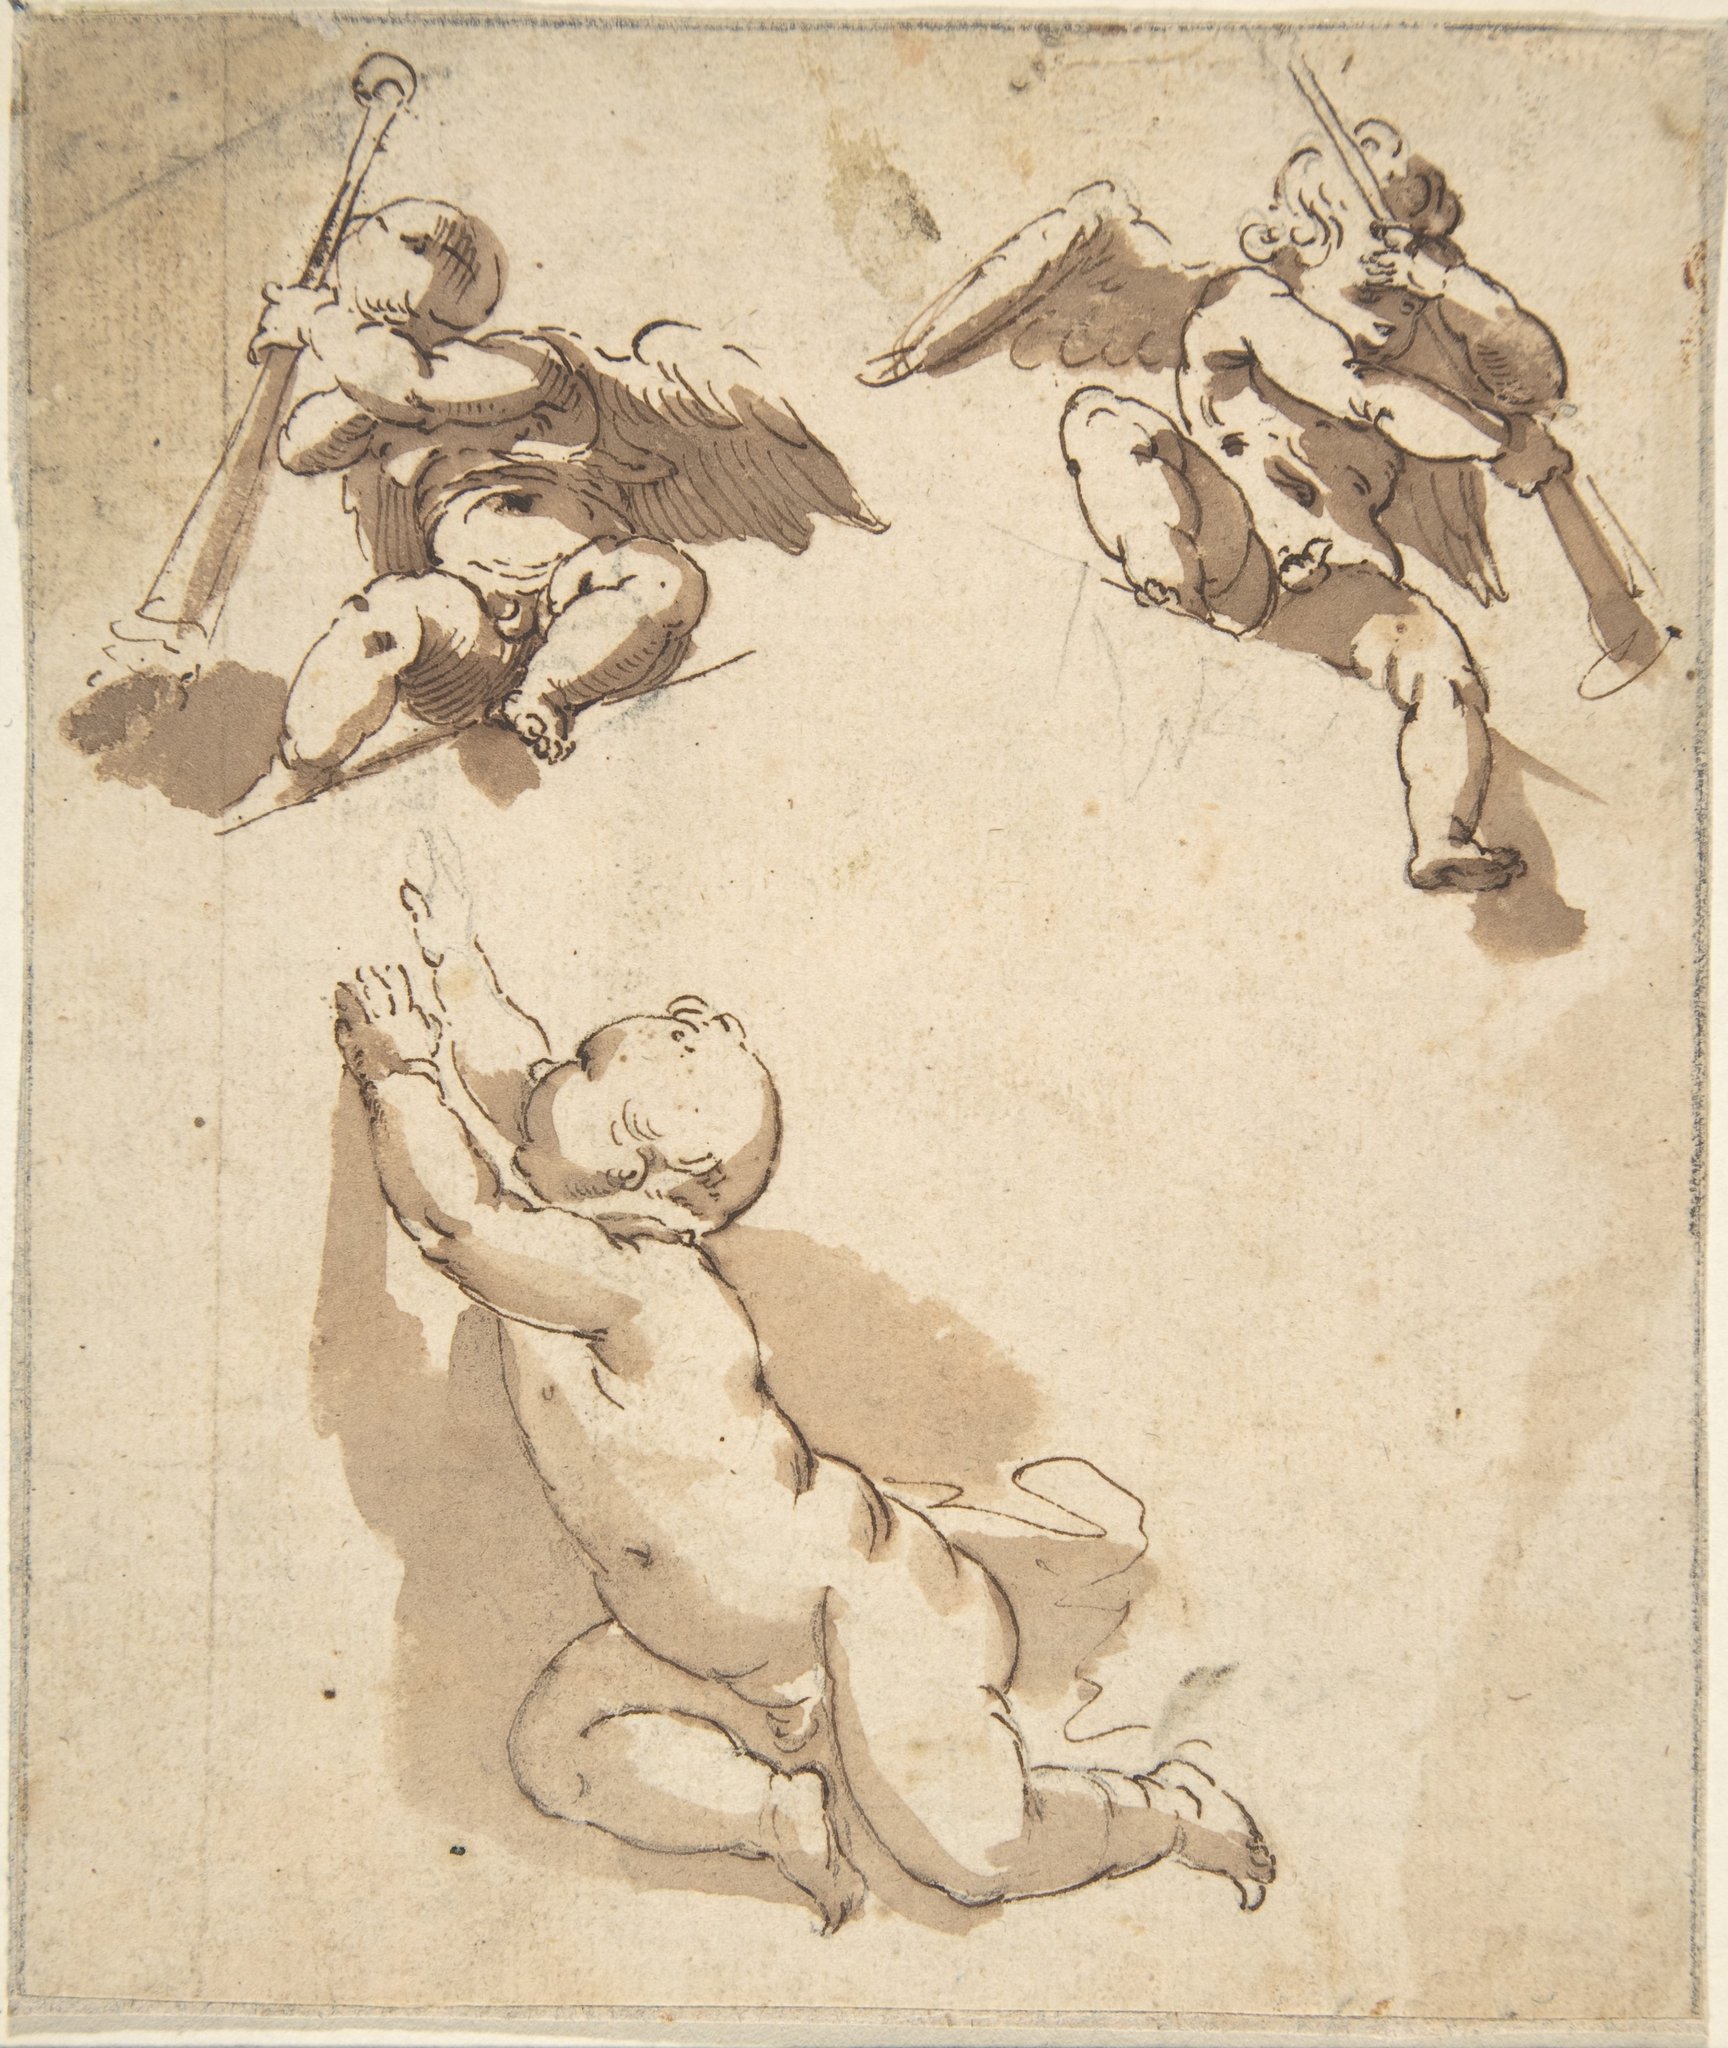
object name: drawing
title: Study of a Child and Two Angels Holding Trumpets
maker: anonymous, spanish, school of seville, 17th century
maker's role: artist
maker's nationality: spanish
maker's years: 1600-1700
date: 1601-1700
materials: chalk, ink, paper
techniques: brush, pen, drawing, wash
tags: infants,trumpets,angels